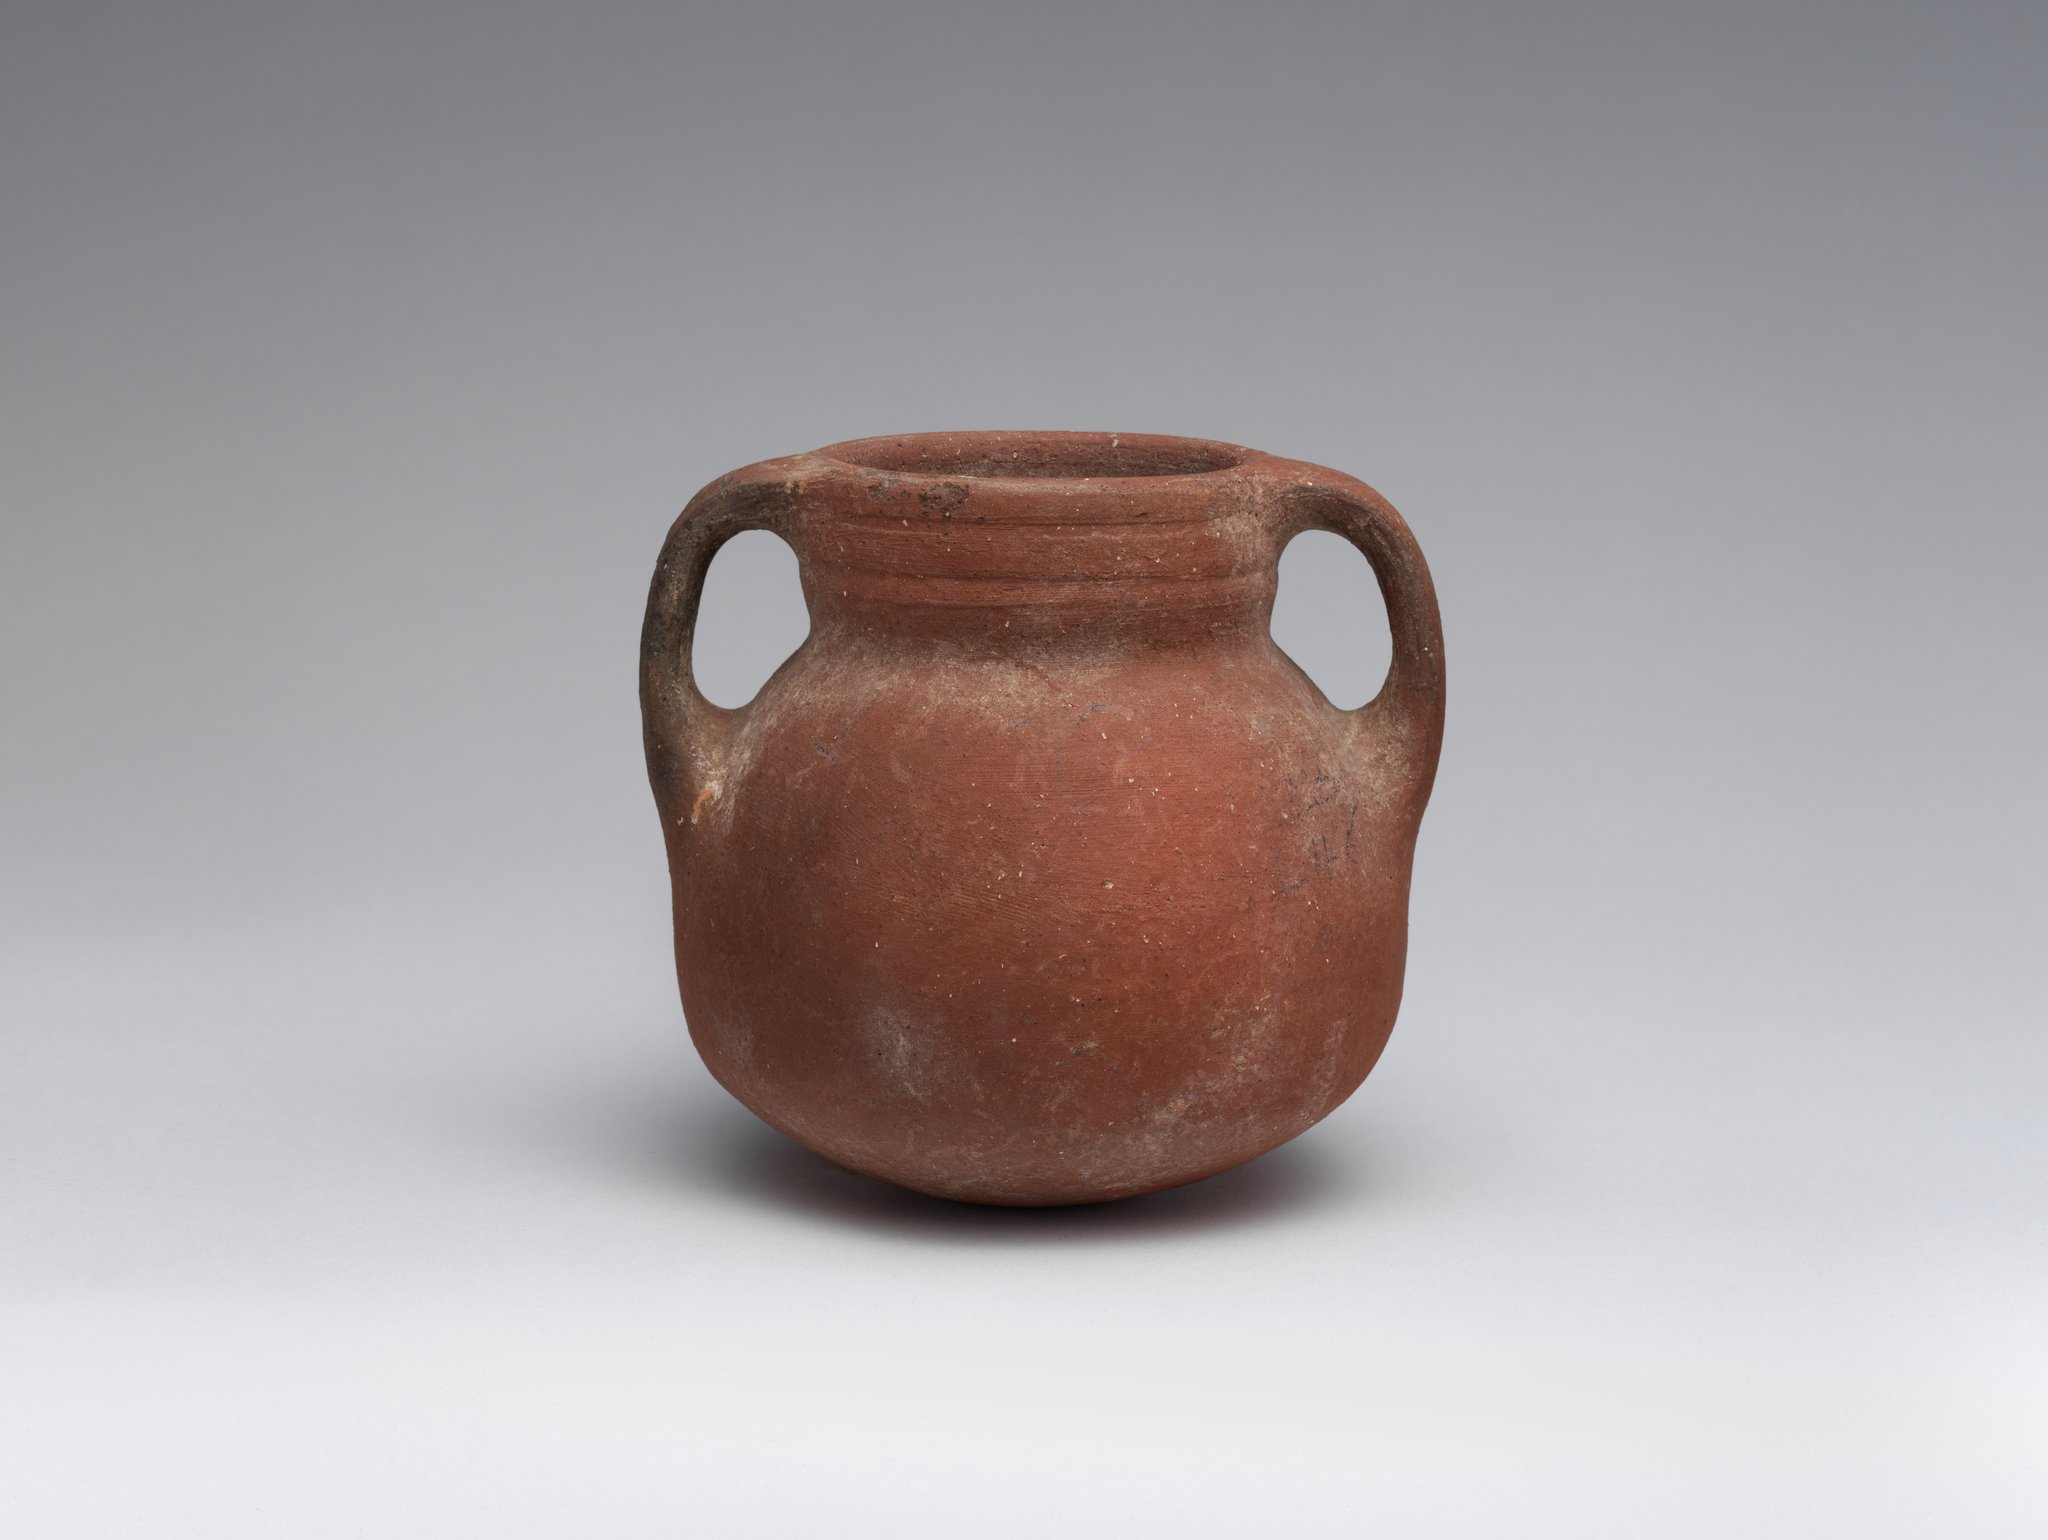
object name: pot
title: Cooking pot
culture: israelite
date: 734-601 BCE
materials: ceramic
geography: levant